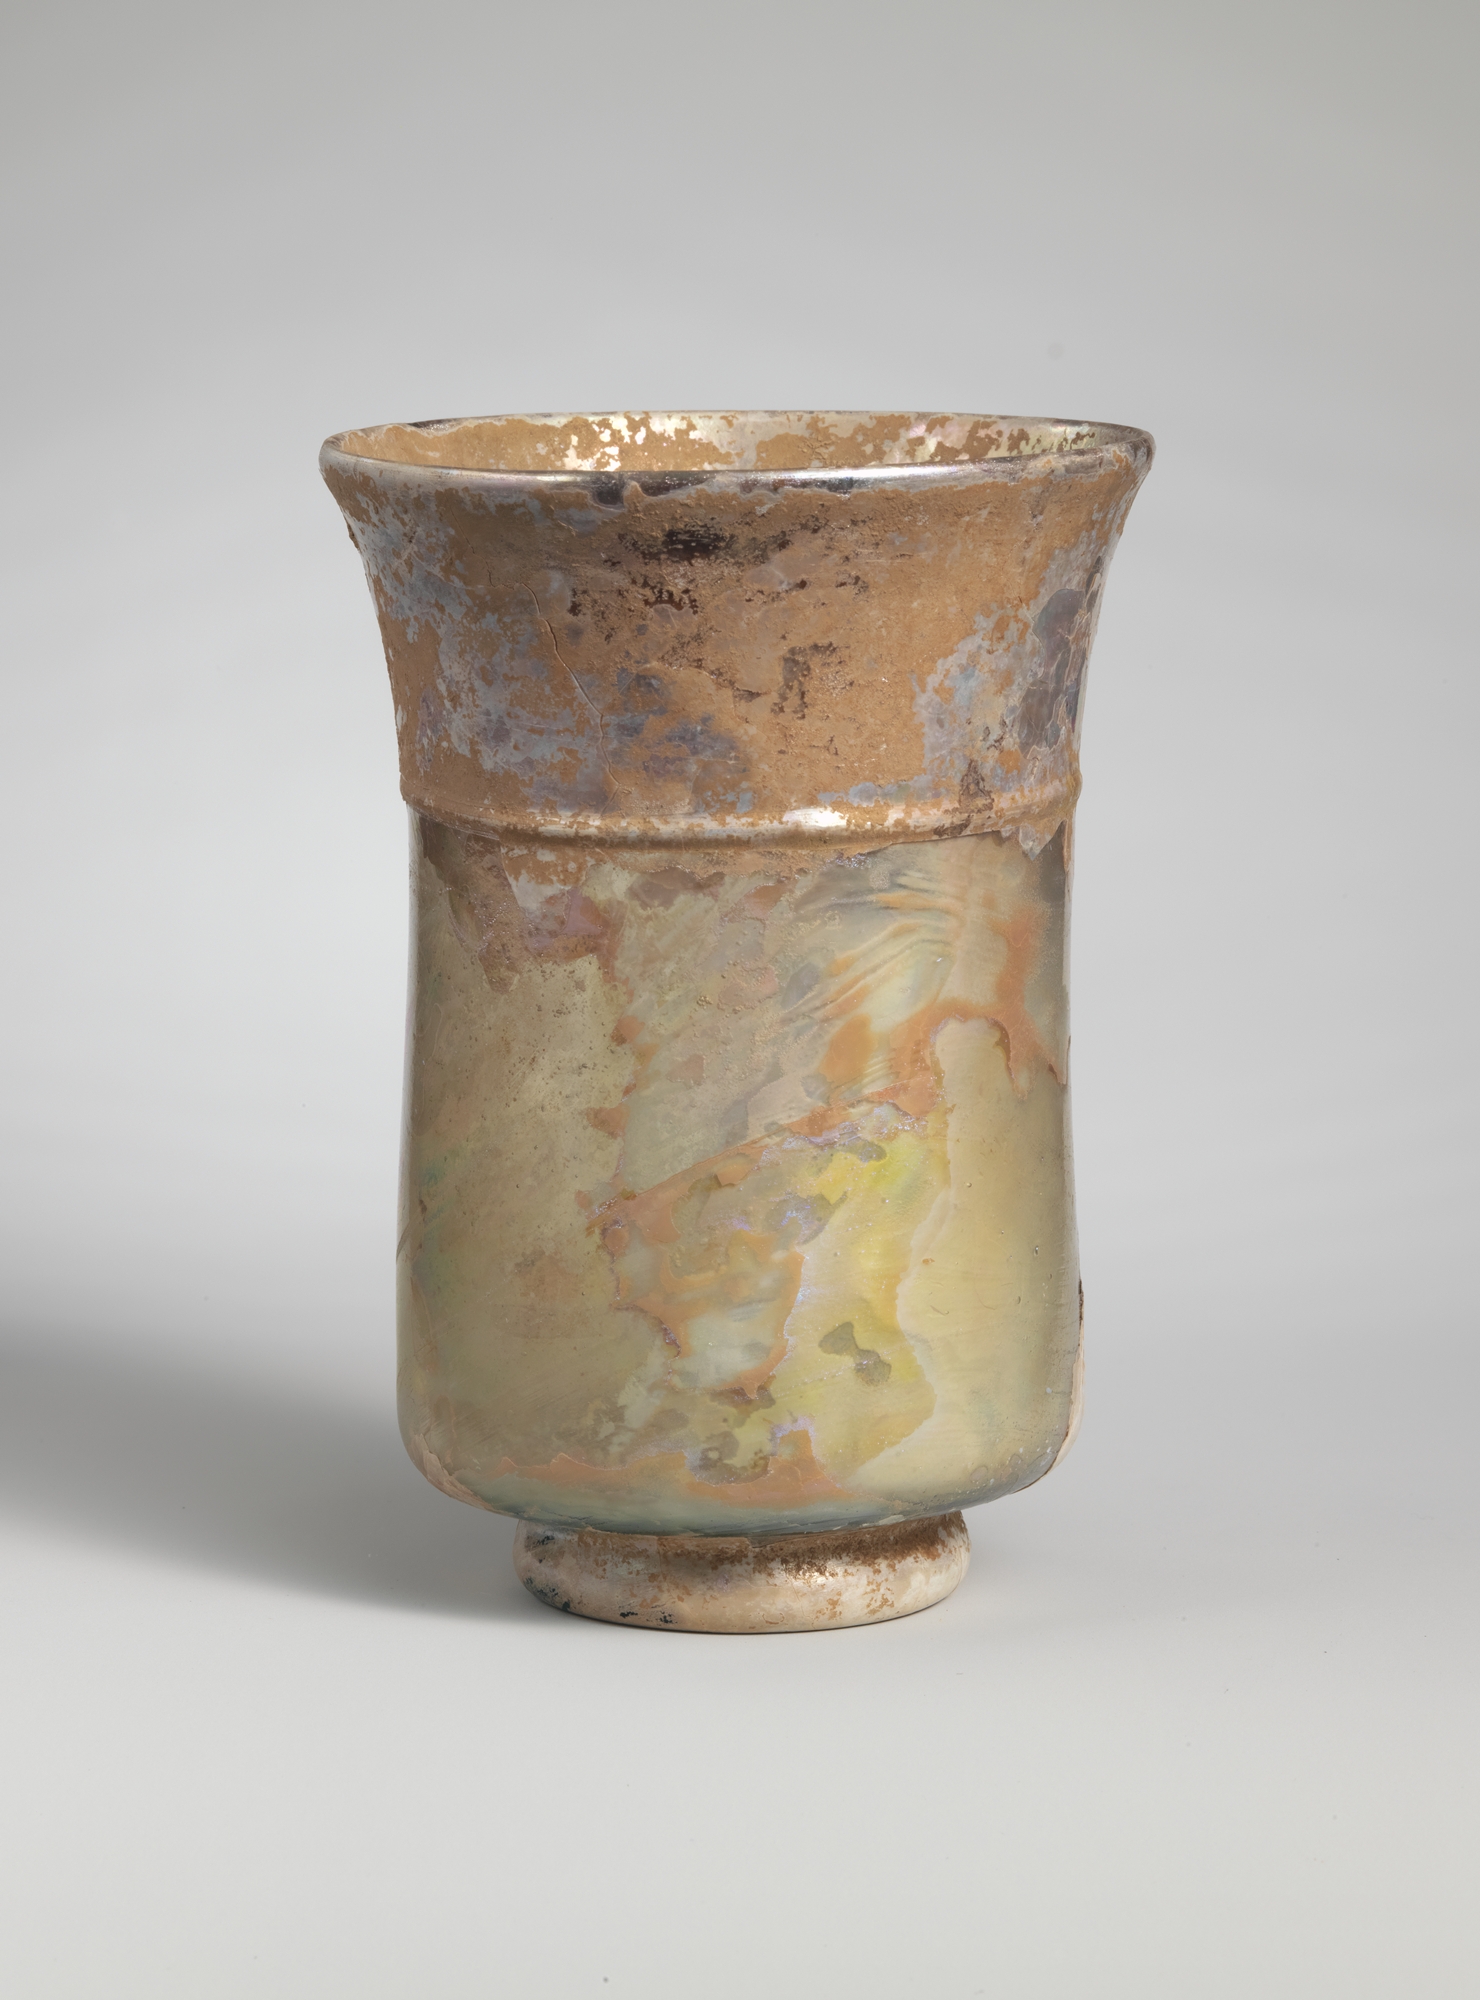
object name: beaker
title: Glass beaker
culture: roman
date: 301-400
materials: glass